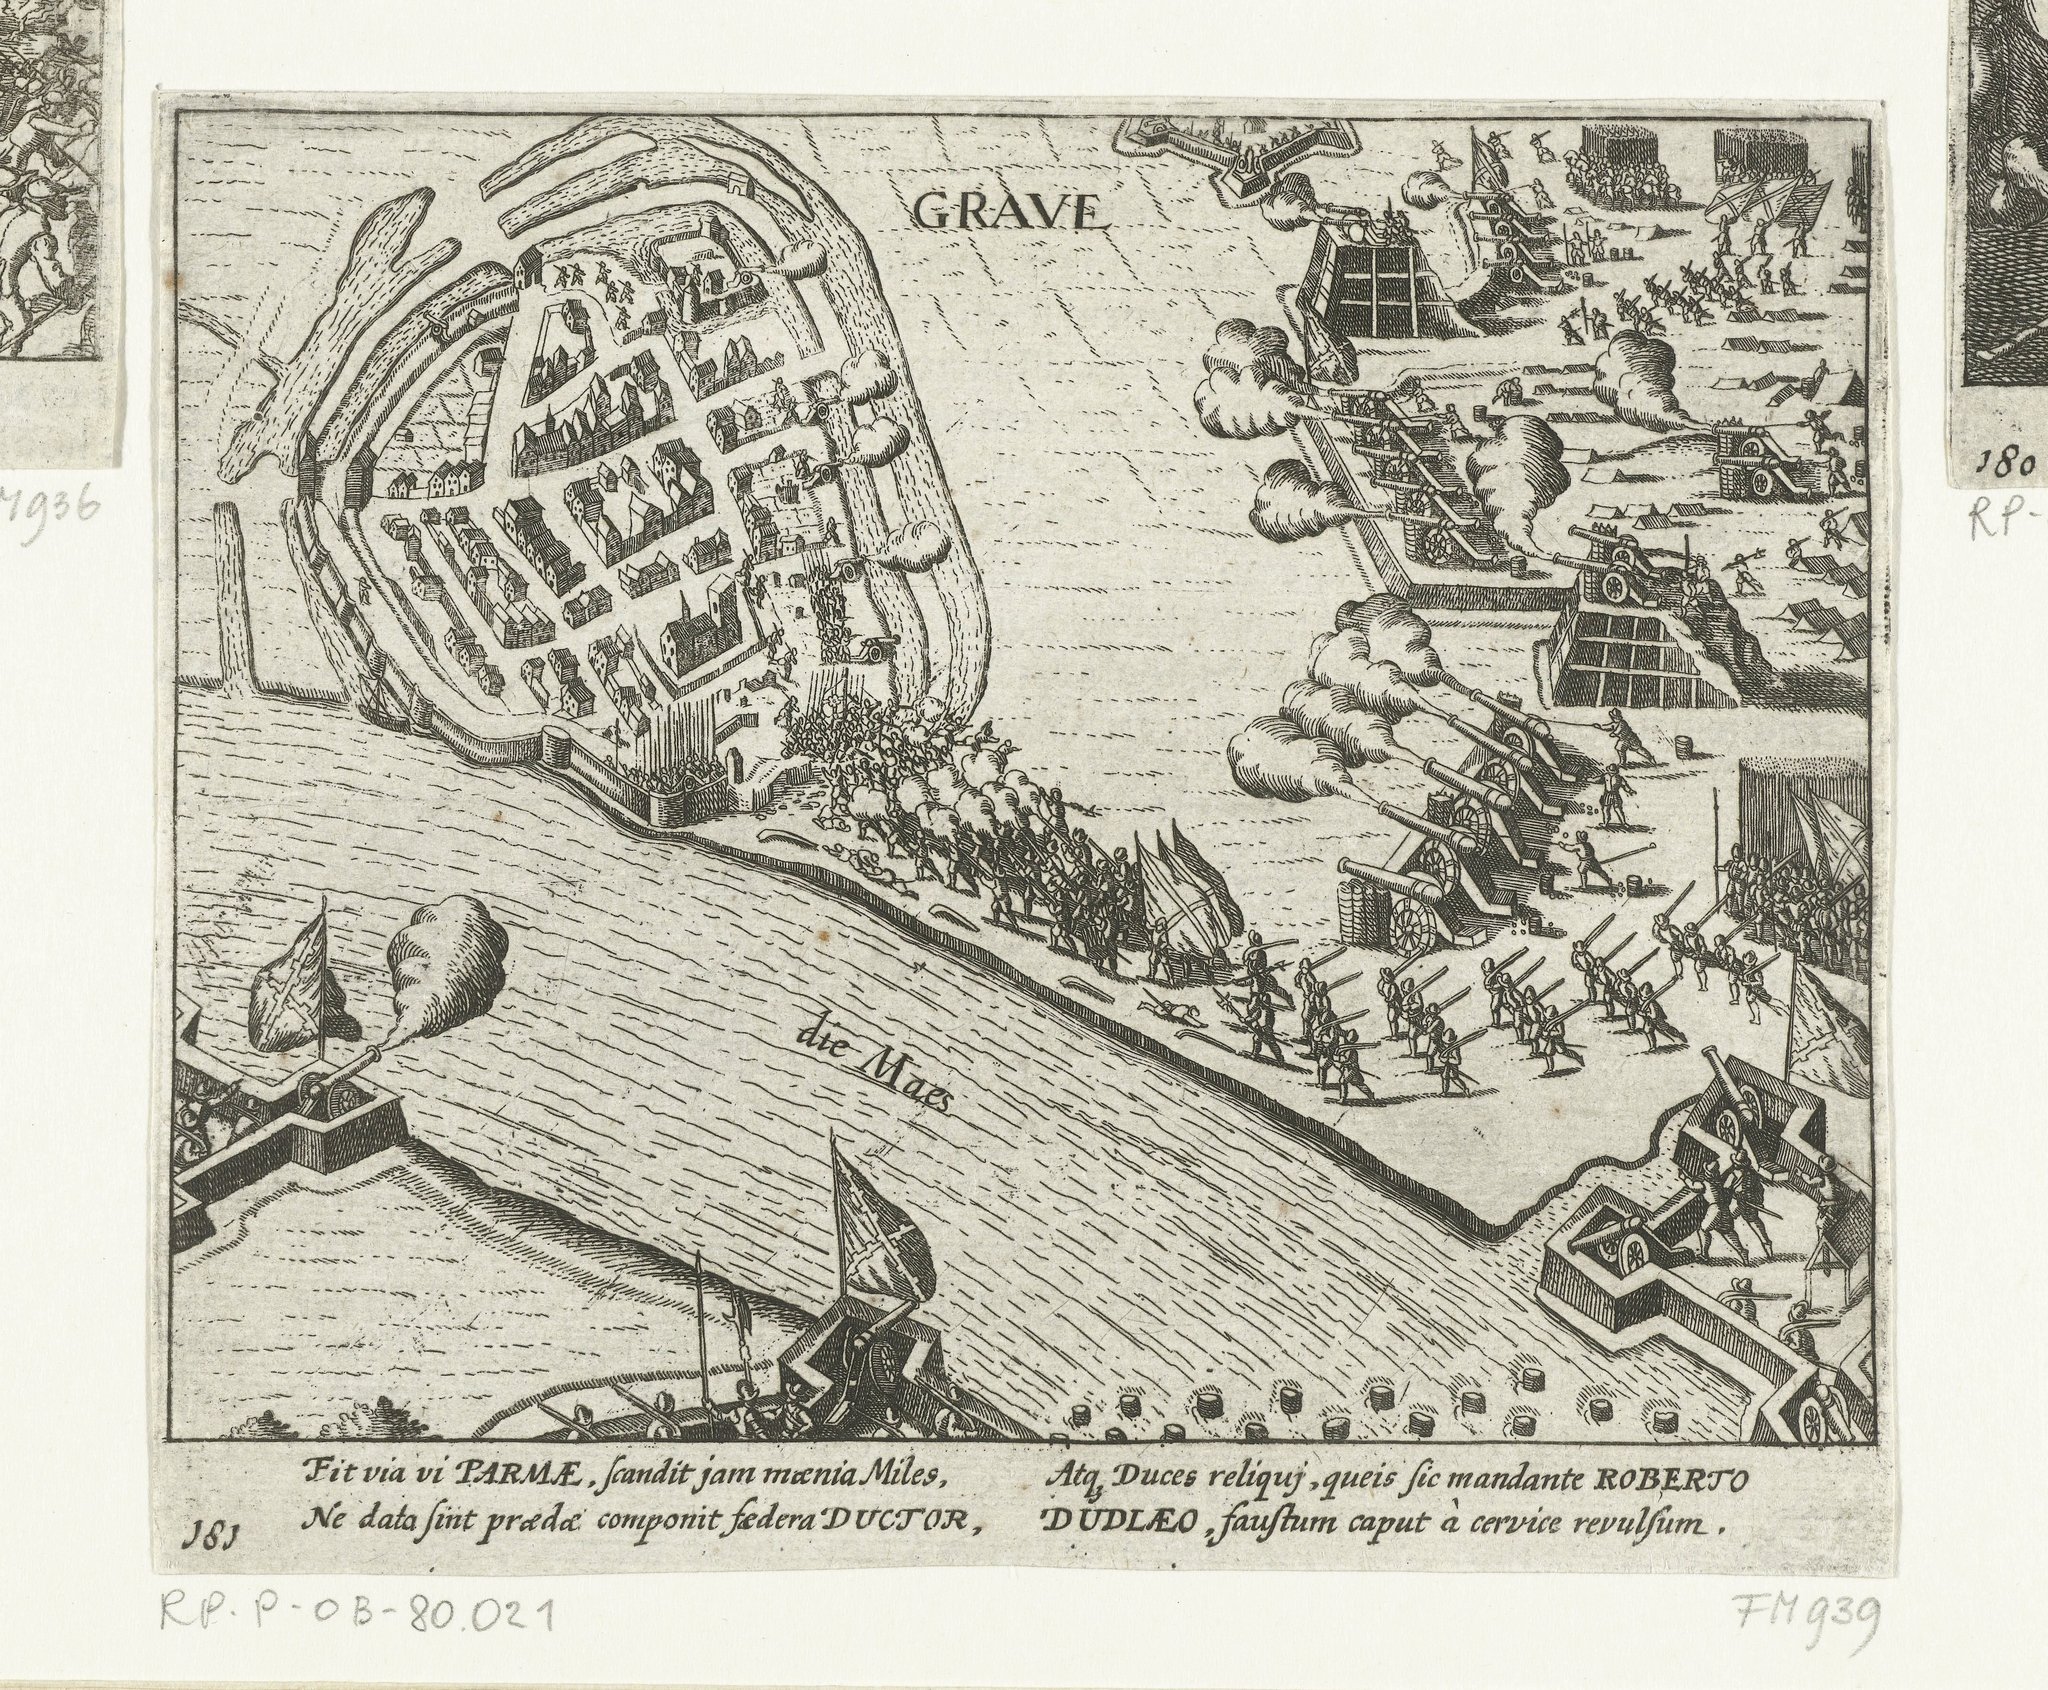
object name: history print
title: Inname van Grave door Parma, 1586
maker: Anonymous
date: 1613-1615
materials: paper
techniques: etching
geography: northern netherlands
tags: capture of city (after the siege), grave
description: Beleg en inname van Grave door Parma, 6 juni 1586. Het leger van Parma bestormt een bres in de muren. Op de voorgrond de Maas. Met onderschrift van 4 regels in het Latijn. Genummerd 181. Bedrukt op achterzijde met tekst in het Latijn.